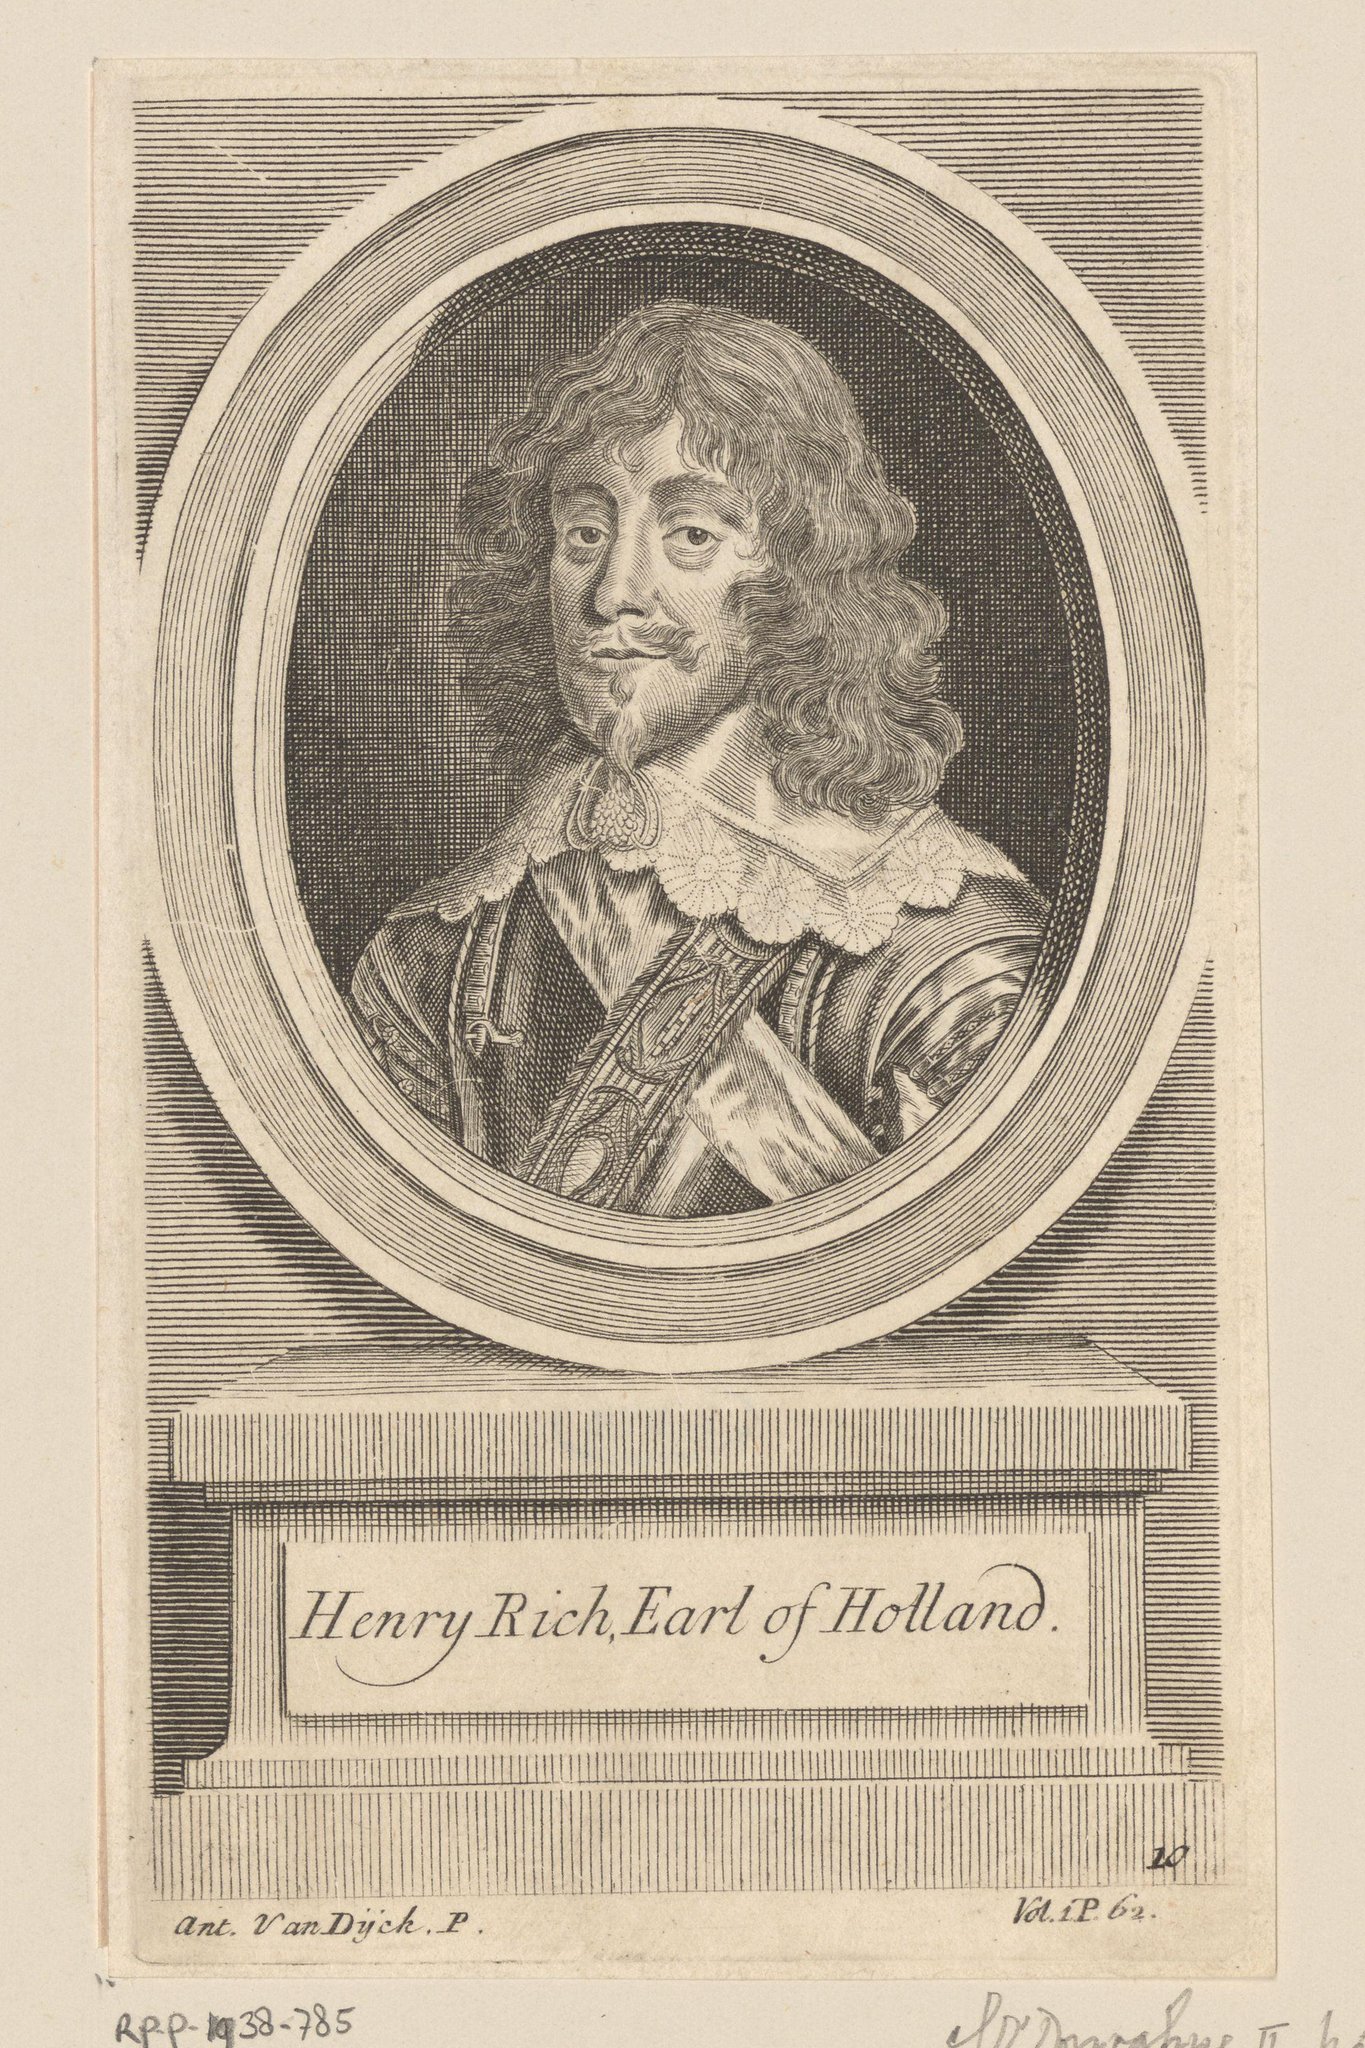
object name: print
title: Portret van Henry Rich, graaf van Holland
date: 1600-1649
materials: paper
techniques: engraving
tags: earl, adult man, historical persons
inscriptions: collector's mark: Lugt 2228